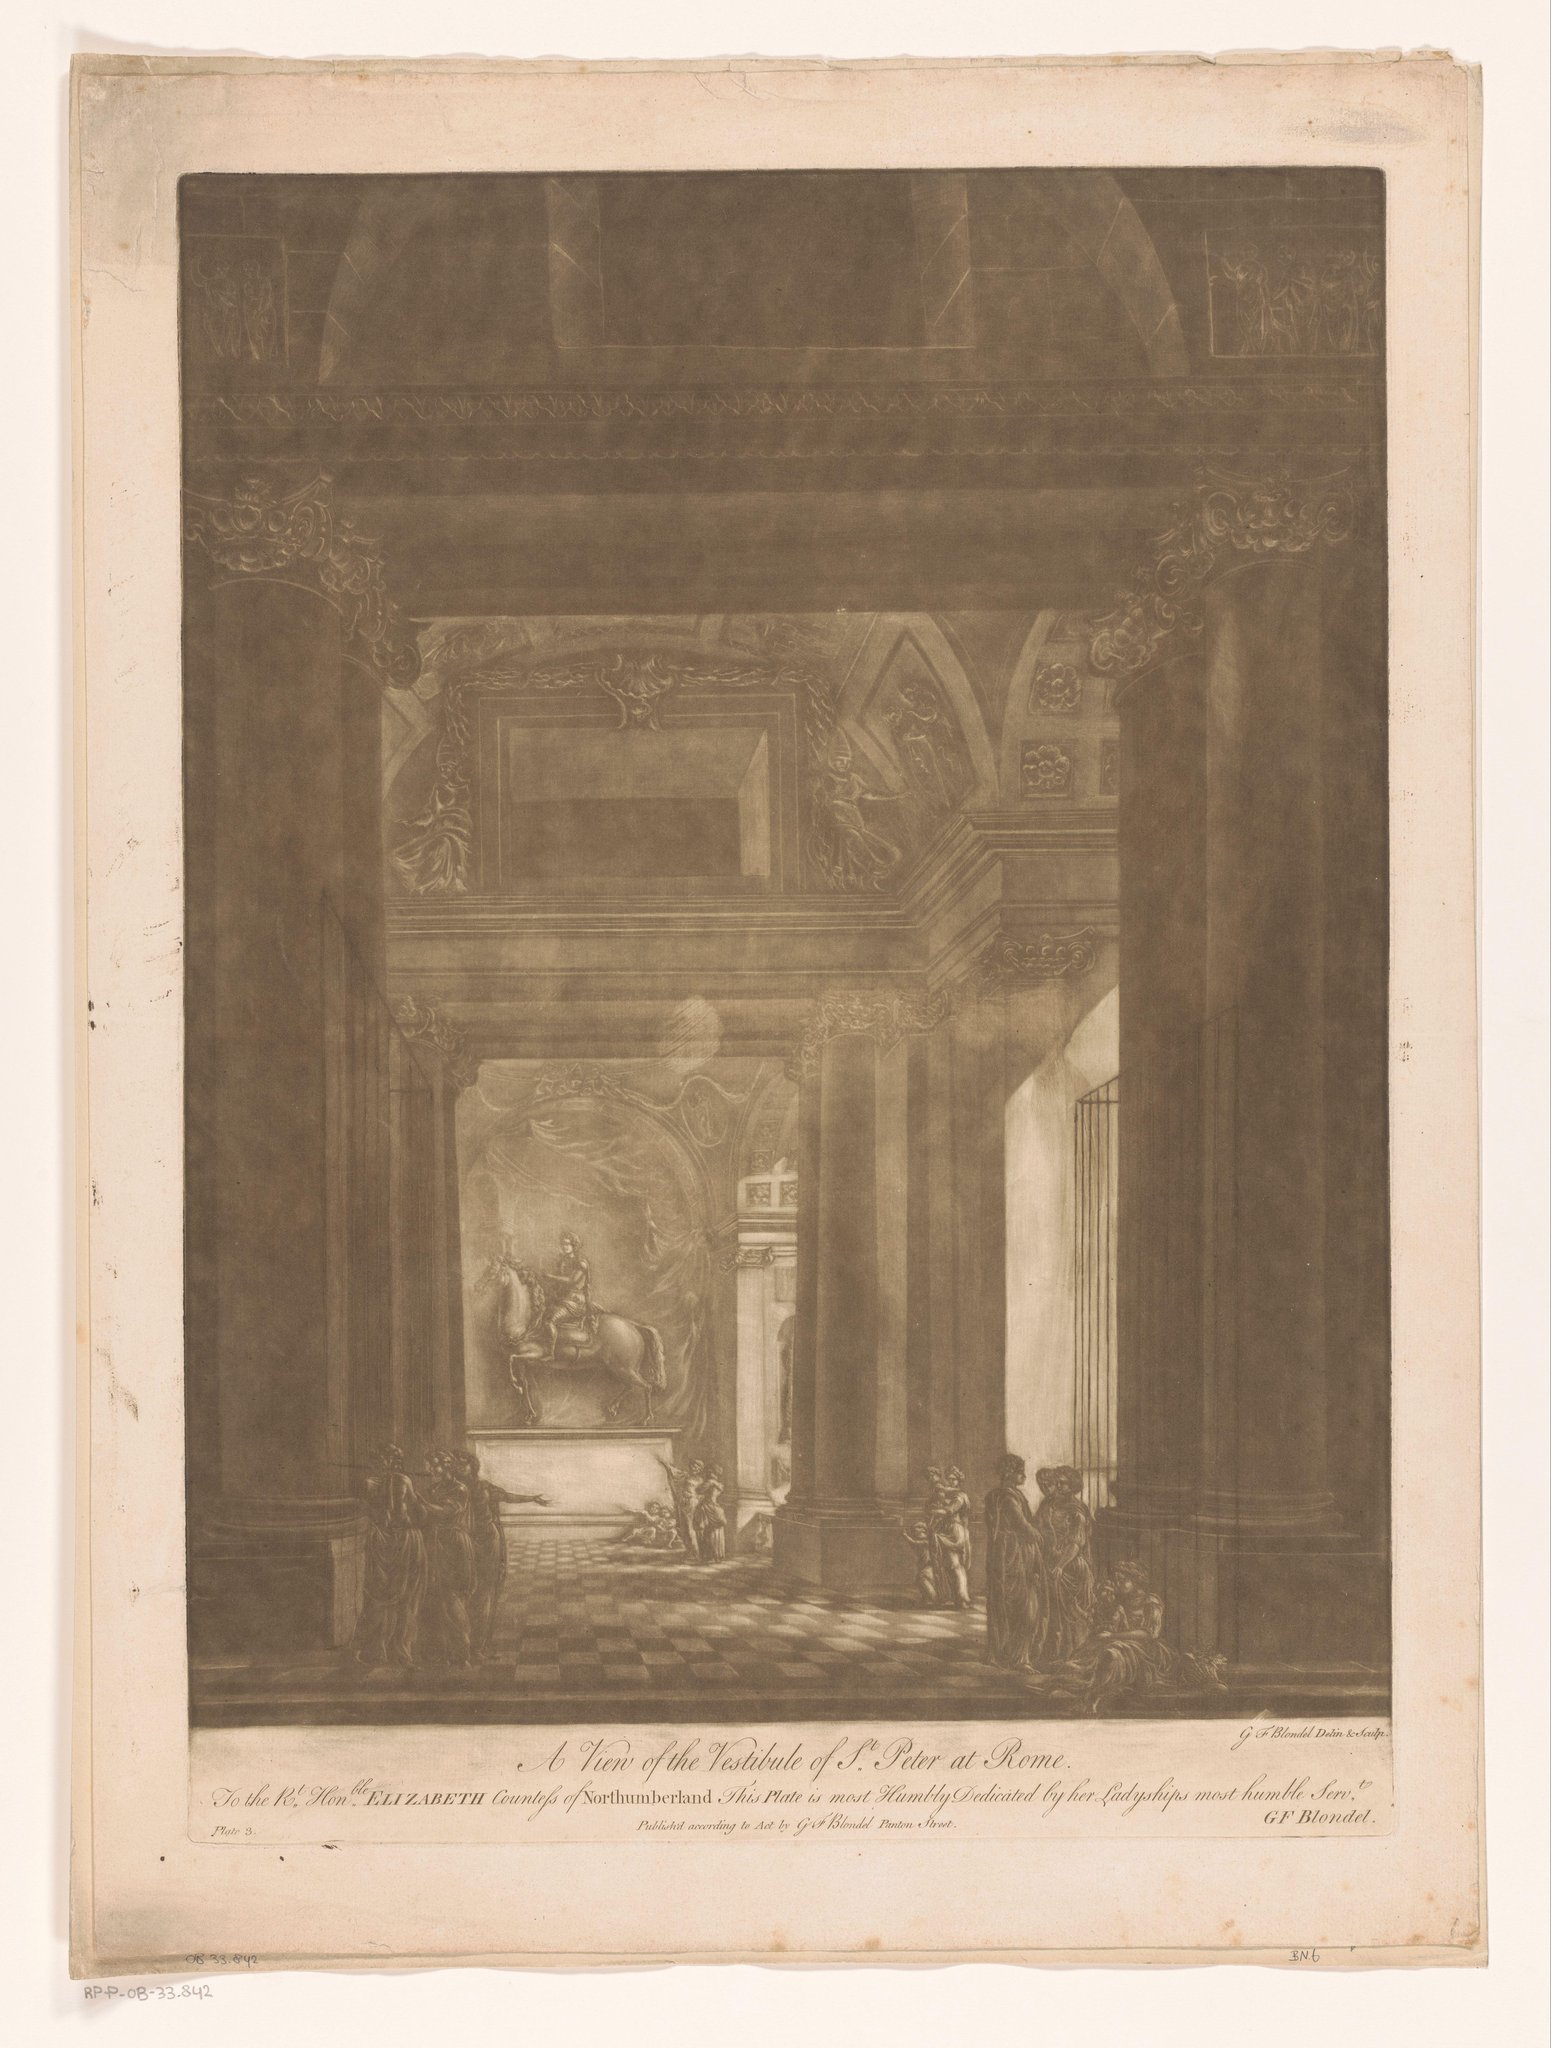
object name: print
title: Interieurs van gebouwen in Rome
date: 1765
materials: paper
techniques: mezzotint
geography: london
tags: interior of church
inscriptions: collector's mark: Lugt 240